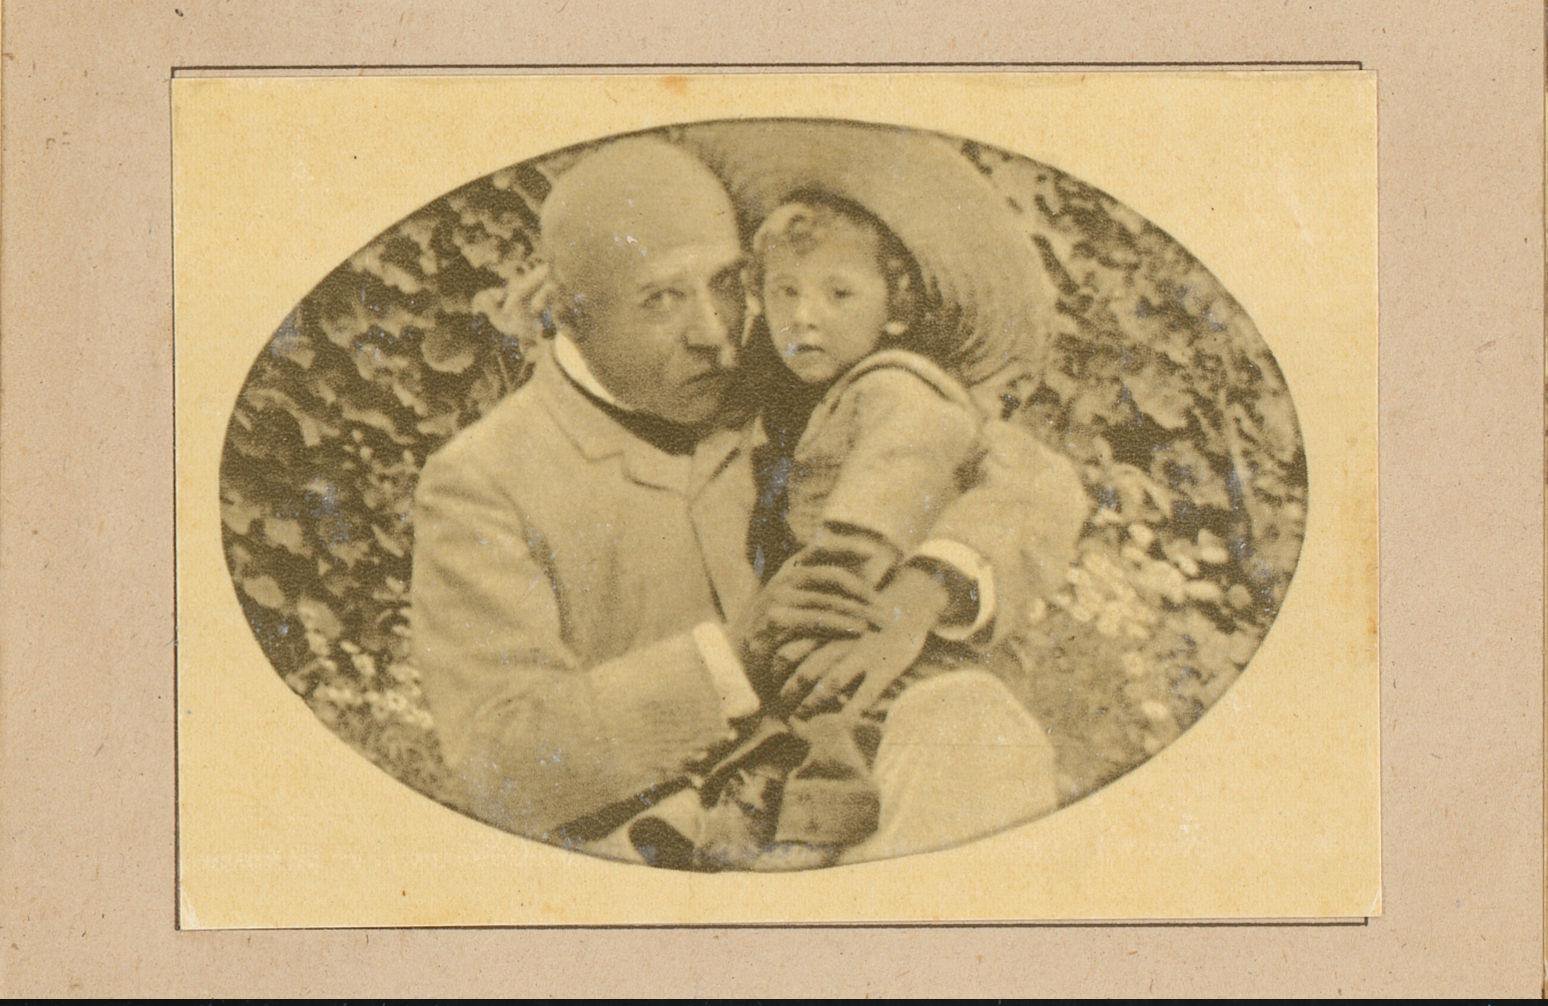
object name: photograph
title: Georges Clemenceau met een kind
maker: Anonymous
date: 1897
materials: paper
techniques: rotogravure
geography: france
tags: paris, politician, e.g. party leader, france